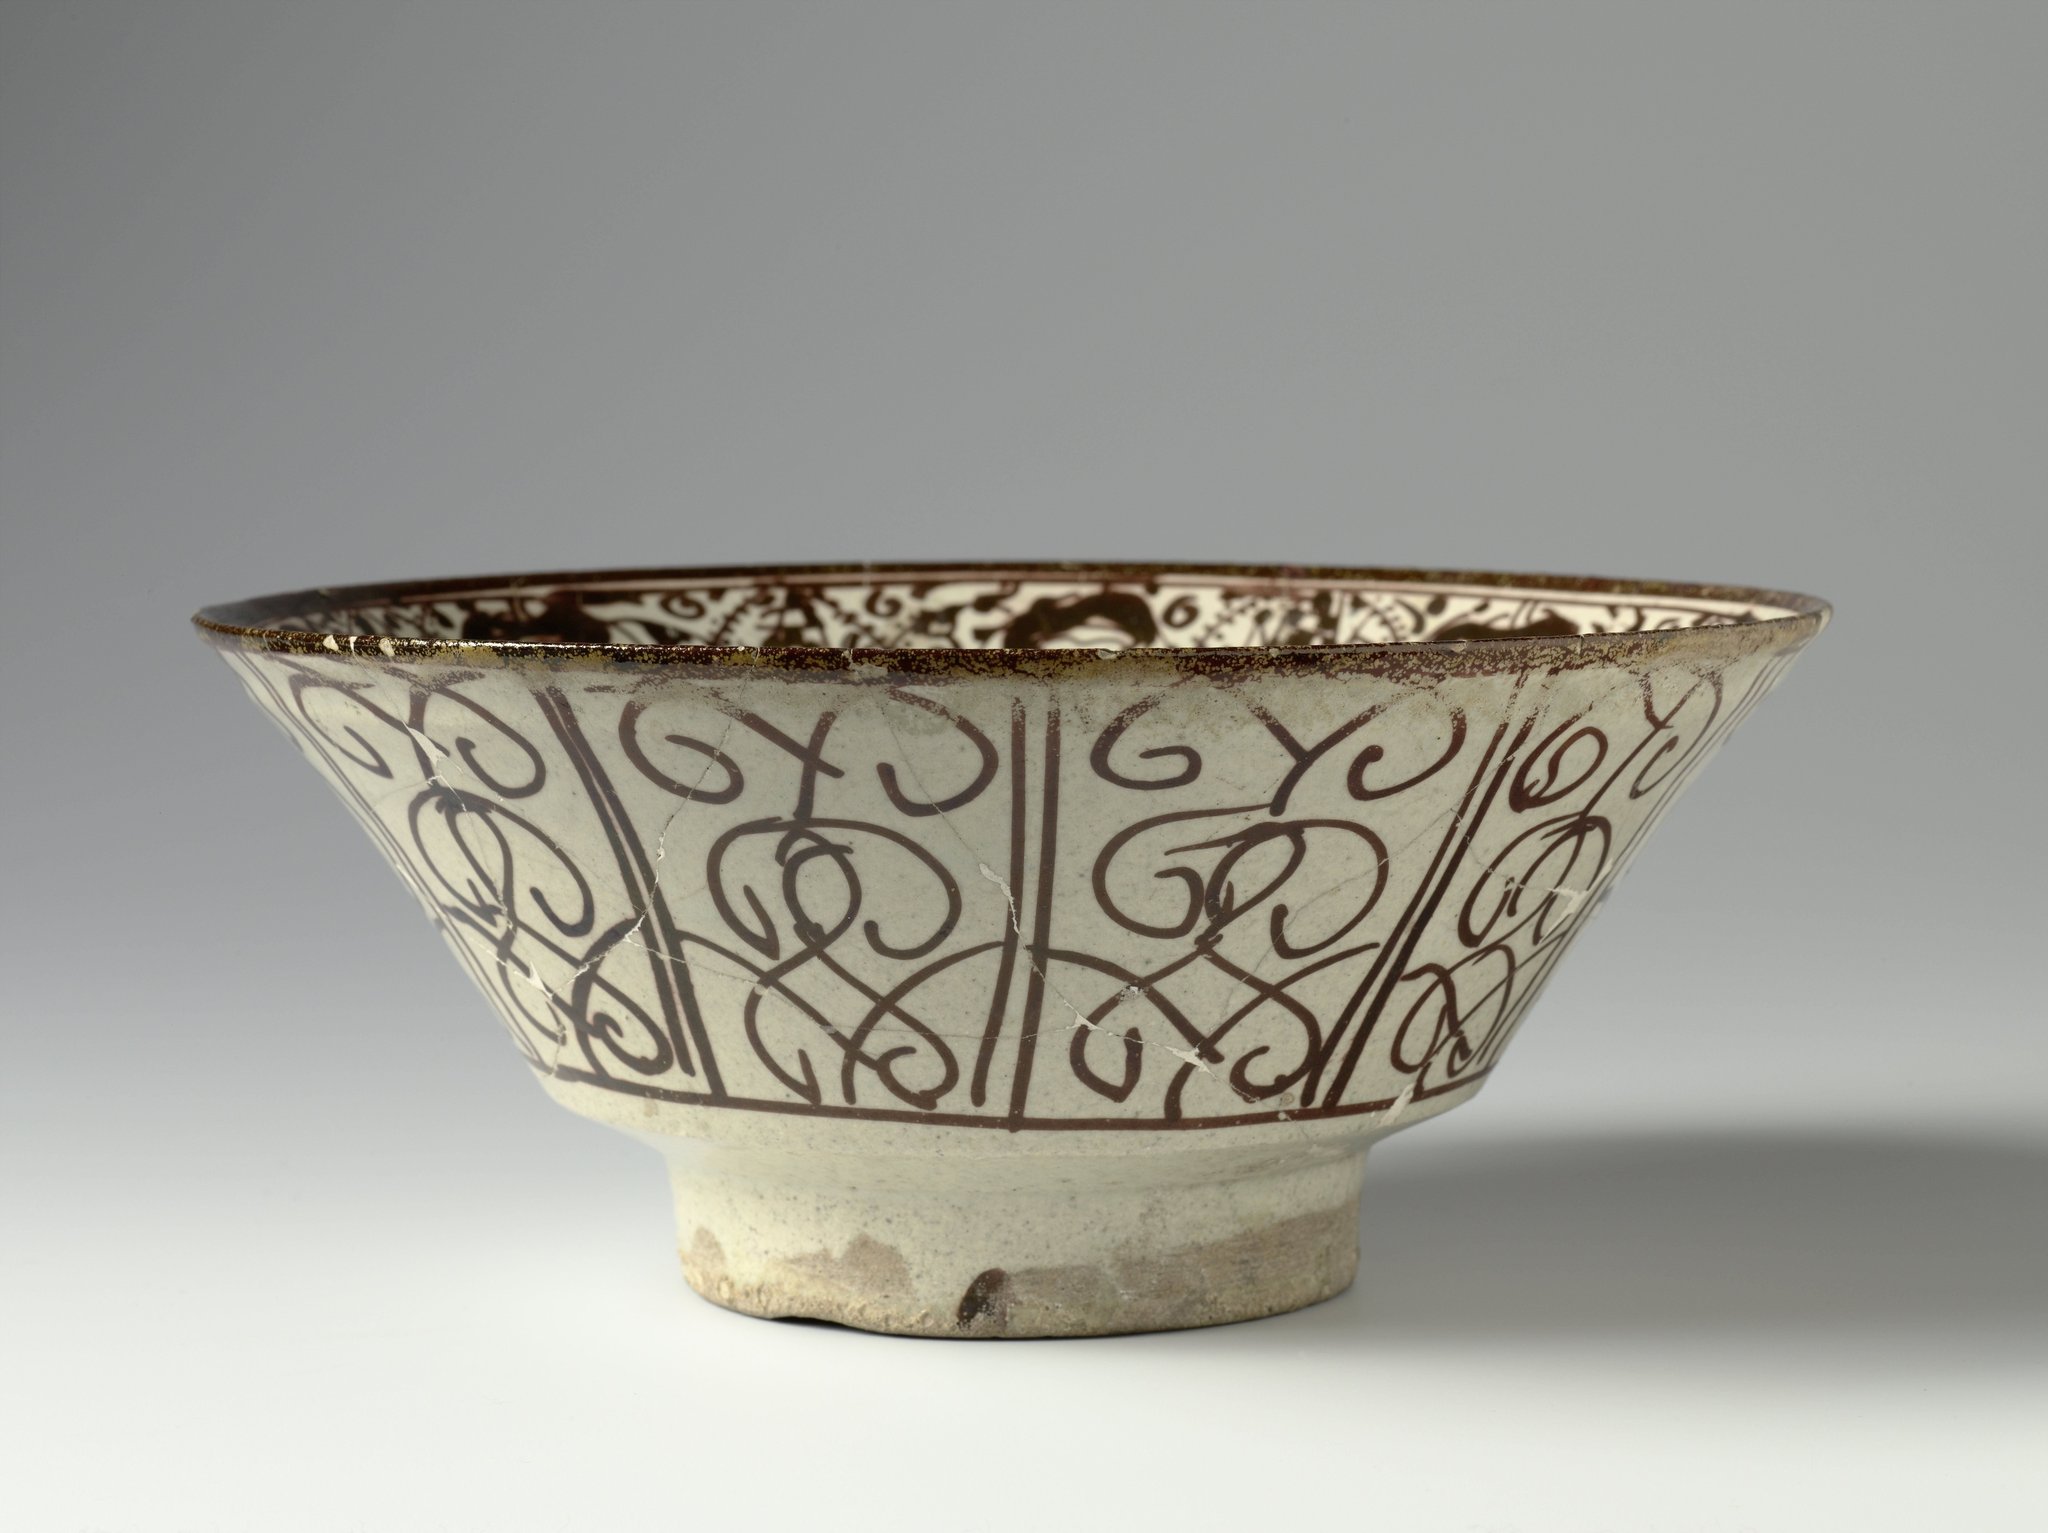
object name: bowl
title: Bowl with Lustre Decoration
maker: Anonymous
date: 1170-1200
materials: earthenware, glaze, luster, paint, quartz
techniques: firing, turning, vitrification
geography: kashan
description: Medieval potters in Iran produced expensive wares with lustre decoration. Lustre glazes were mixed with silver or copper oxide, which lent the earthenware an attractive metallic sheen.